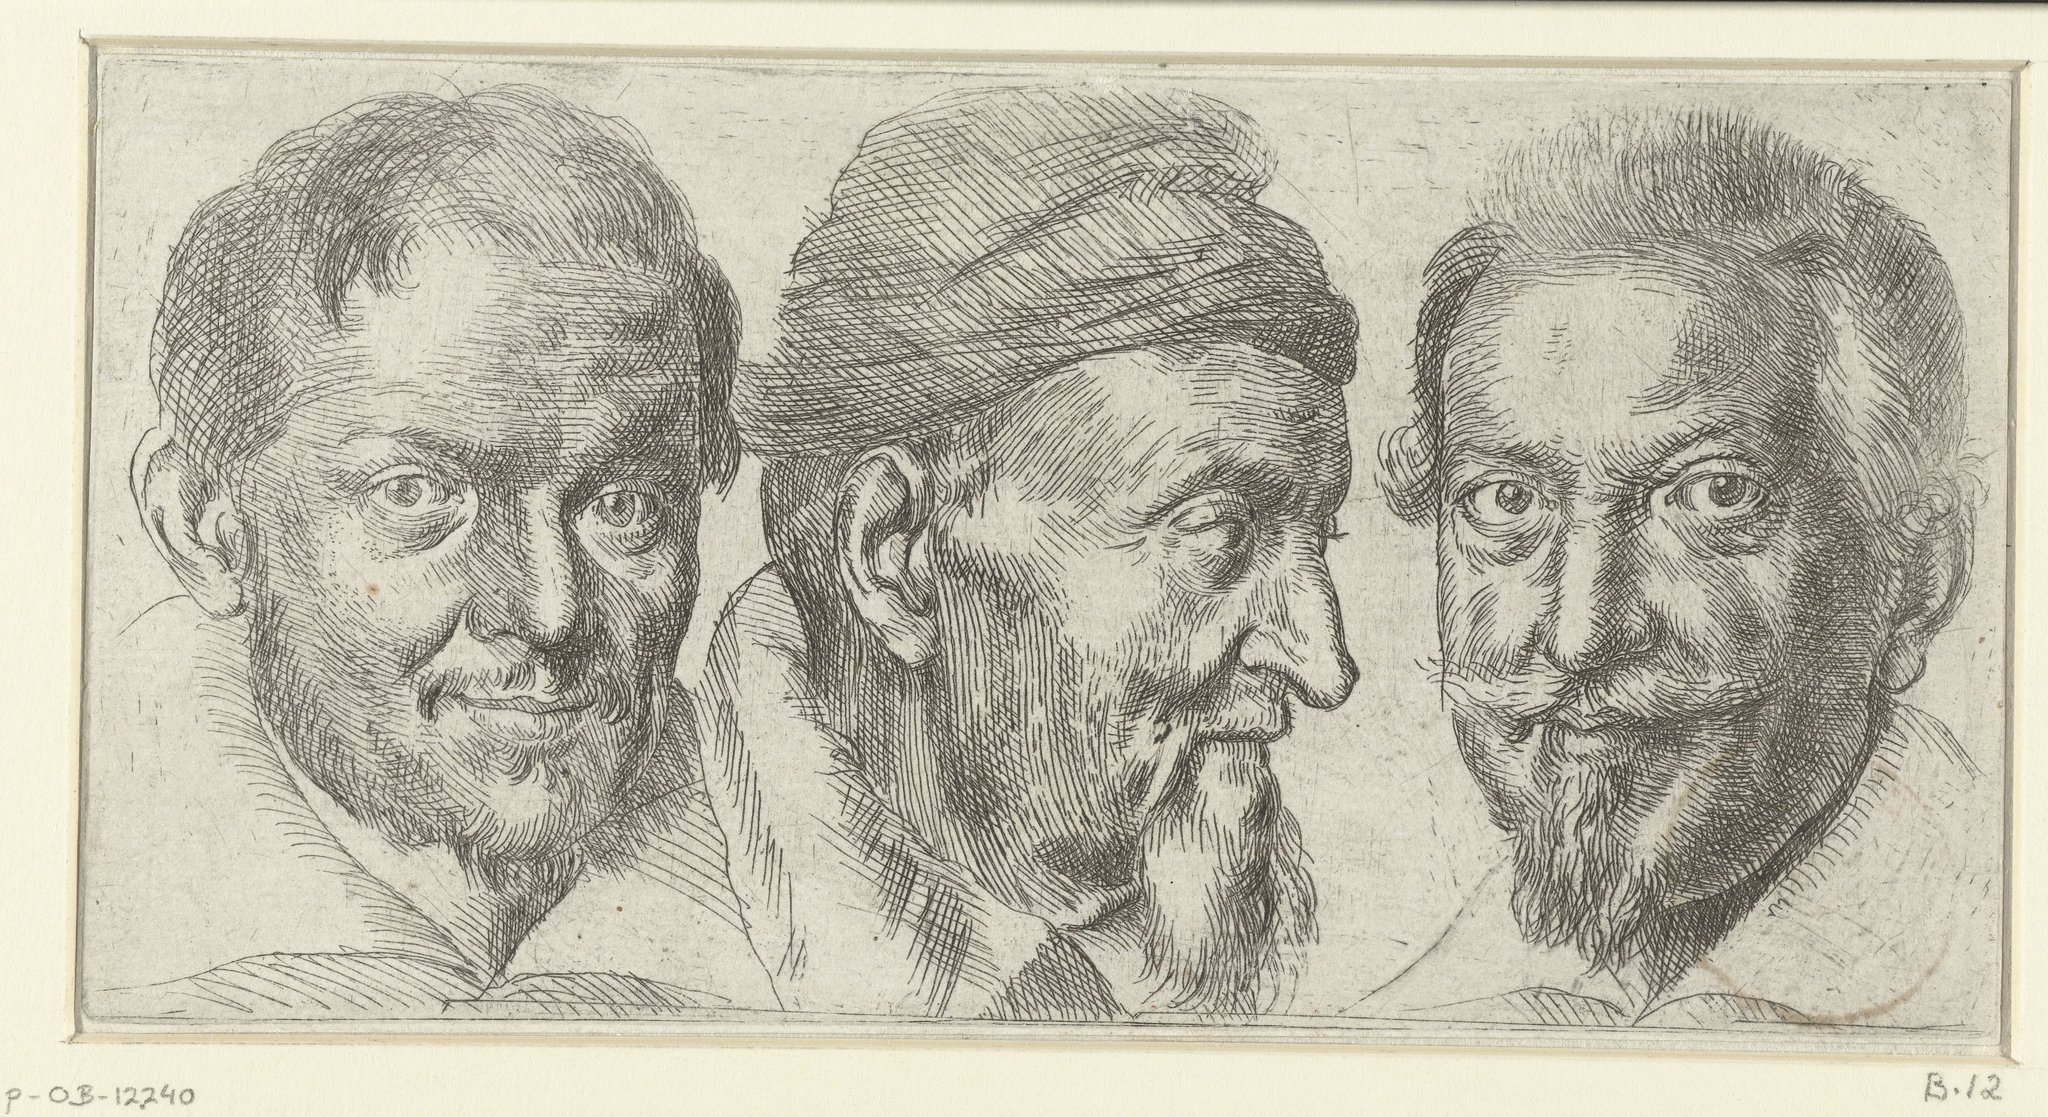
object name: print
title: Portret van Camillo Graffico, Ercole Pedemonte en Antonio Carone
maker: ottavio mario leoni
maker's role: draughtsman, print maker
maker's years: 1578-1630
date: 1588-1630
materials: paper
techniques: etching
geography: italy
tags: print maker, camillo graffico, portrait, self-portrait of artist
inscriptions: collector's mark: Lugt 240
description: Drie koppen van mannen, mogelijk Camillo Graffico, Ercole Pedemonte en Antonio Carone.